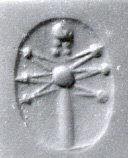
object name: stamp seal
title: Stamp seal (oval conoid) with deity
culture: assyro-babylonian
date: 700-501 BCE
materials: lapis lazuli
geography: mesopotamia